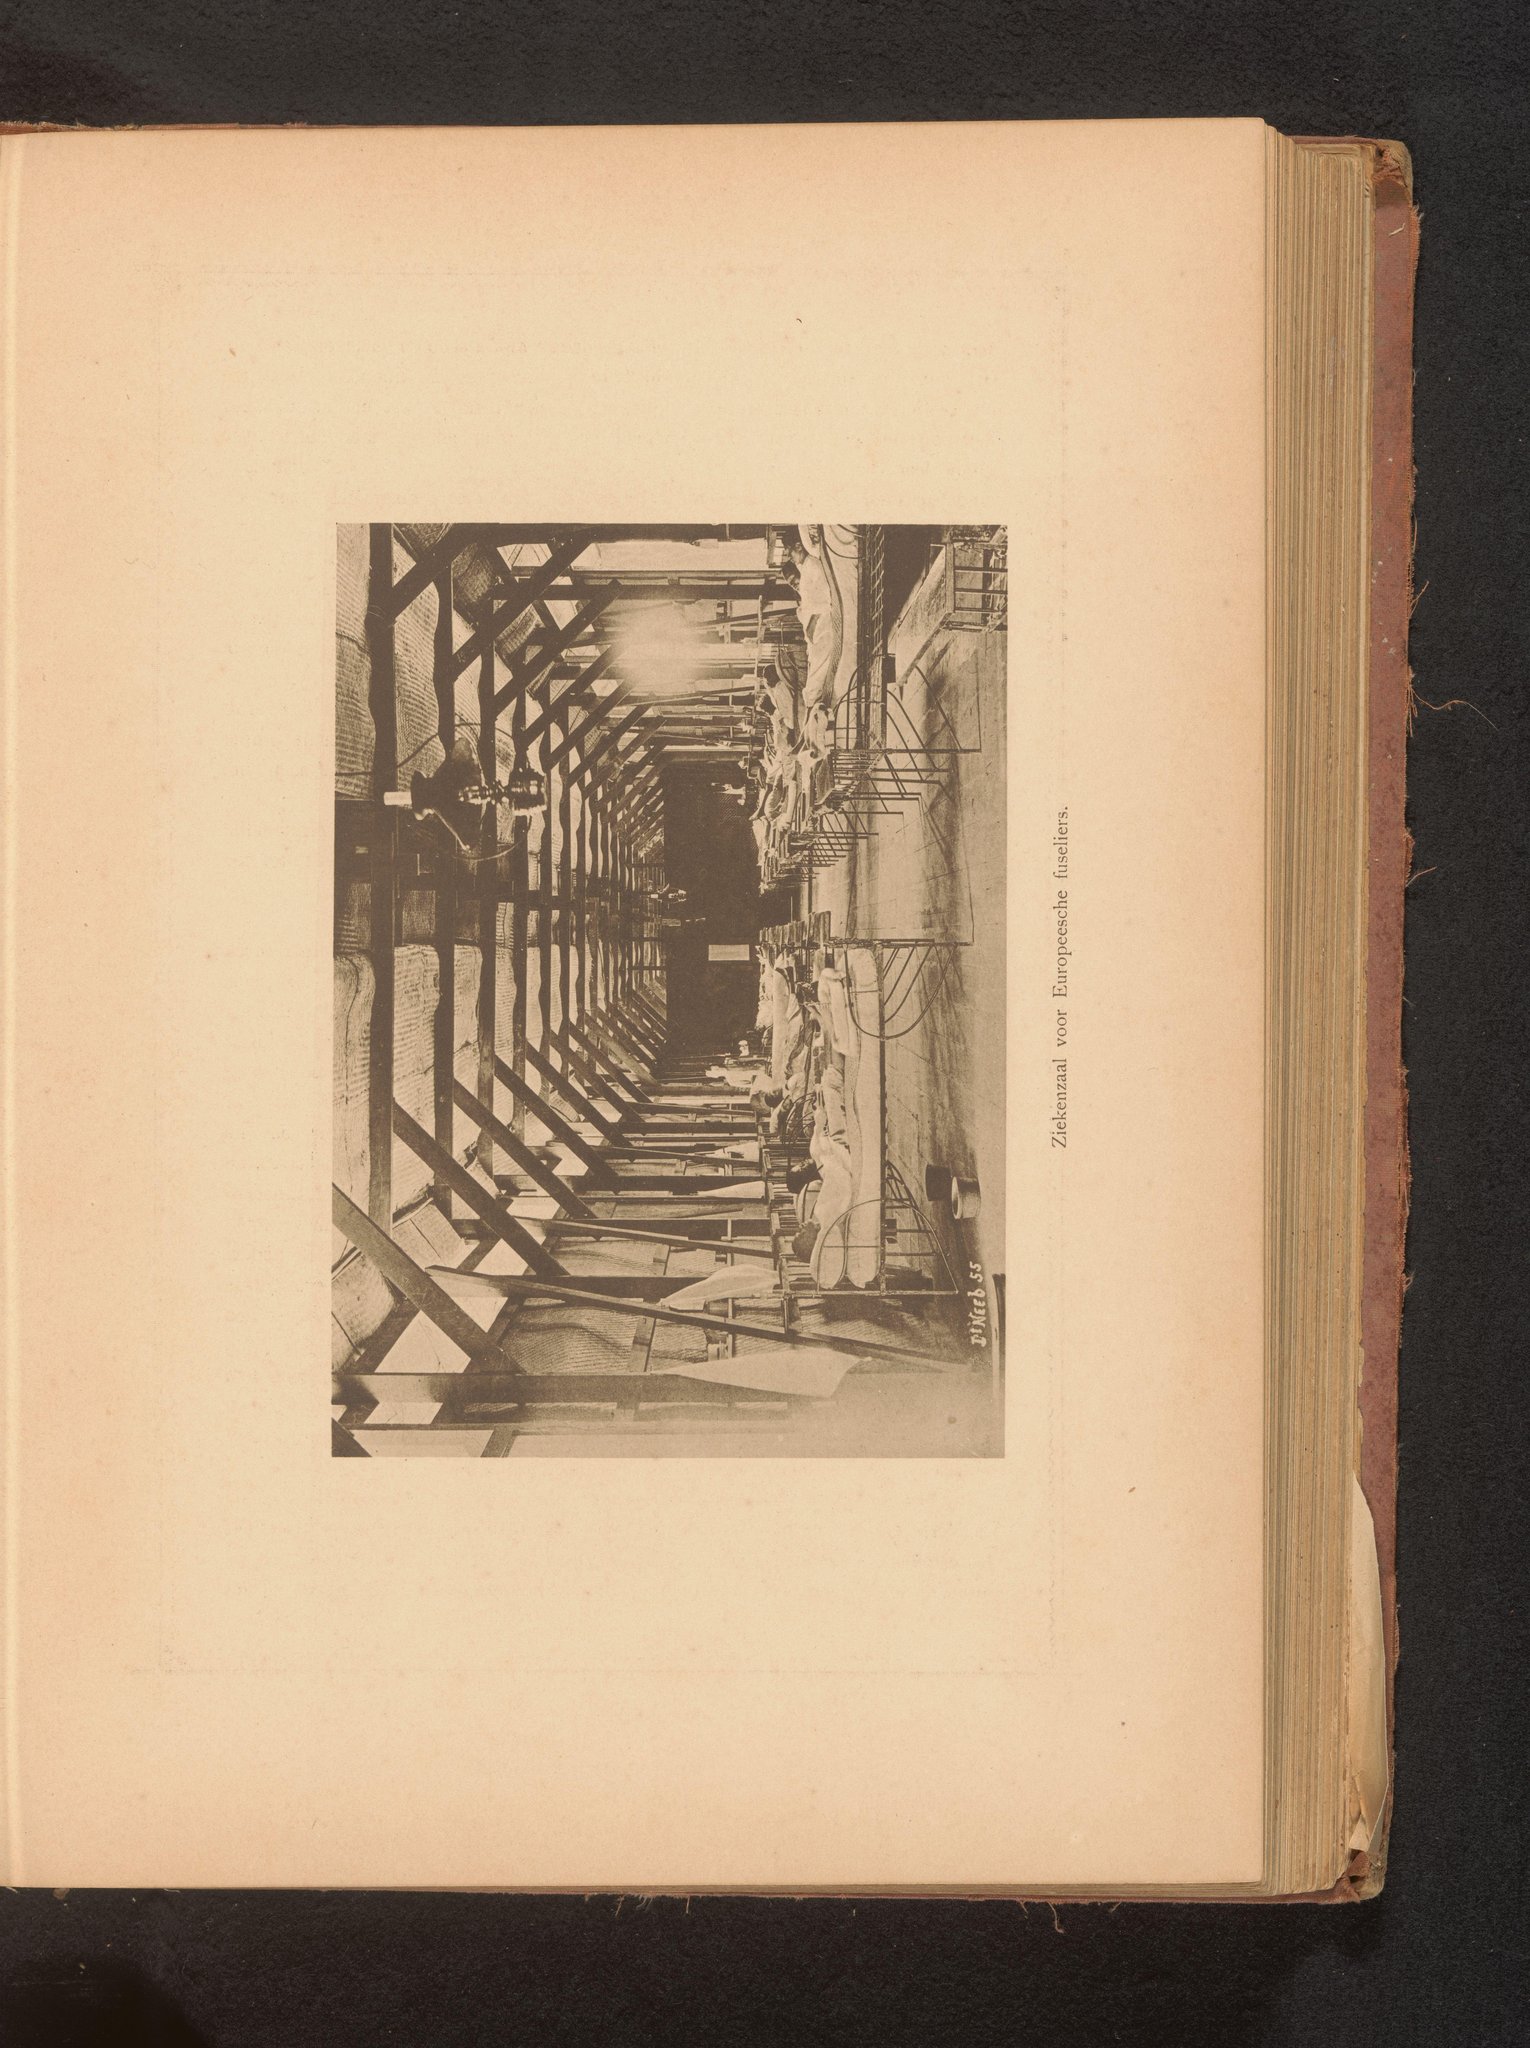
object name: photomechanical print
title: Ziekenzaal voor Europese fuseliers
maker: christiaan johan neeb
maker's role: arts, fotograaf, officier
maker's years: 1860-1925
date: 1892-1897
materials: paper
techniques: photograph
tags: sick-bed, ward; room (in hospital)